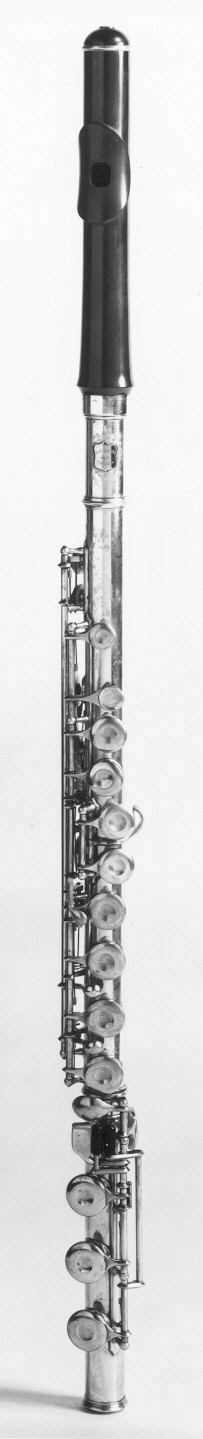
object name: transverse flute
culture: american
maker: alfred g. badger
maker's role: maker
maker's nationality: american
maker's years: 1815-1892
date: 1860-1880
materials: silver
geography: united states